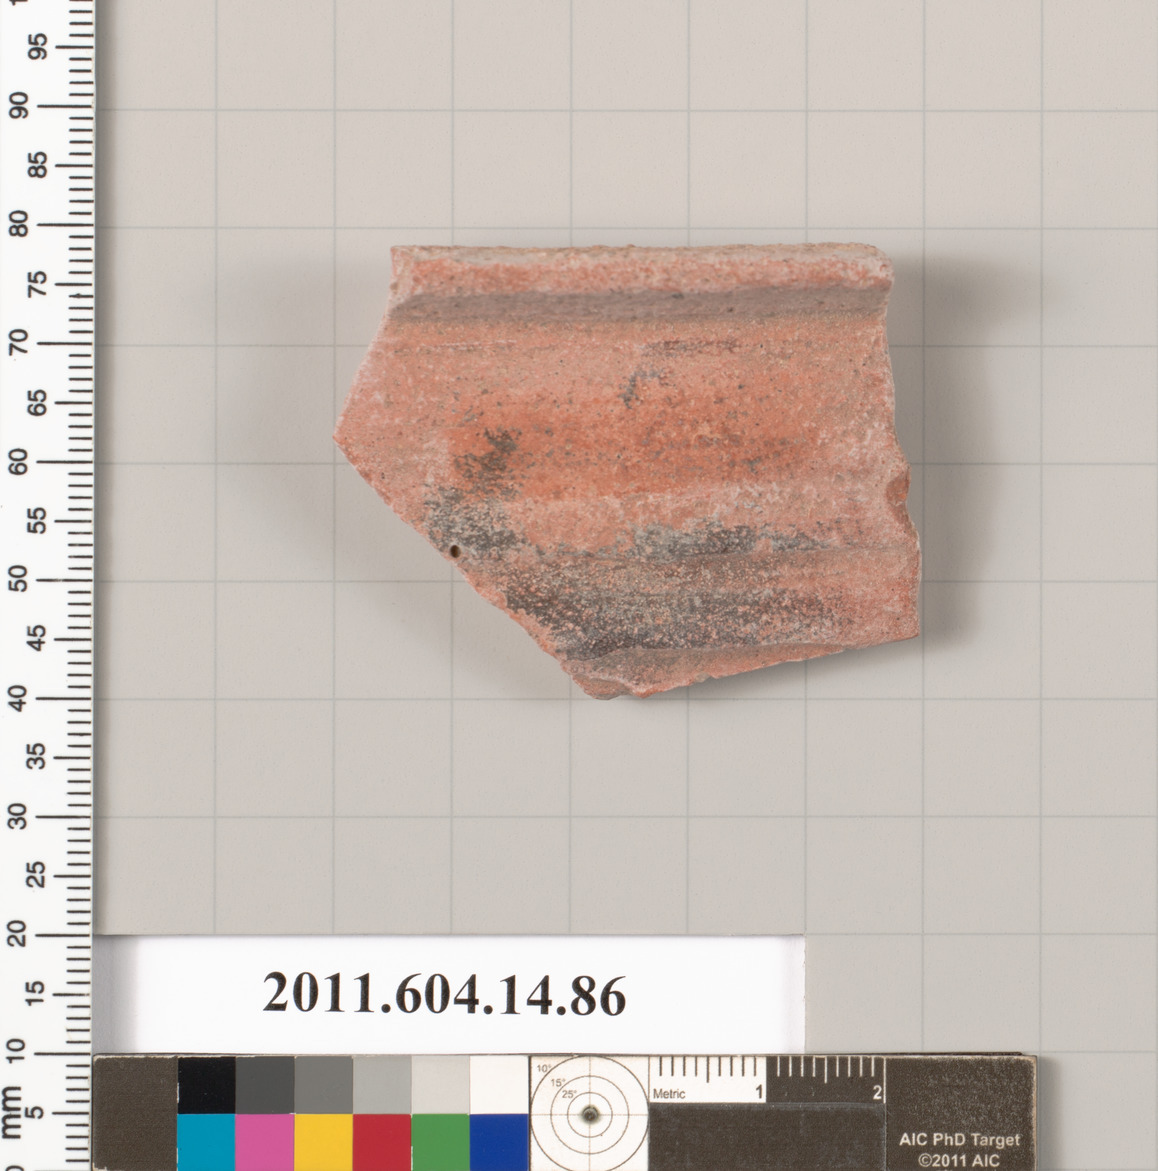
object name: vase fragment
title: Terracotta fragment of a vase?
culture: unknown fabric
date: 700-301 BCE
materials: terracotta